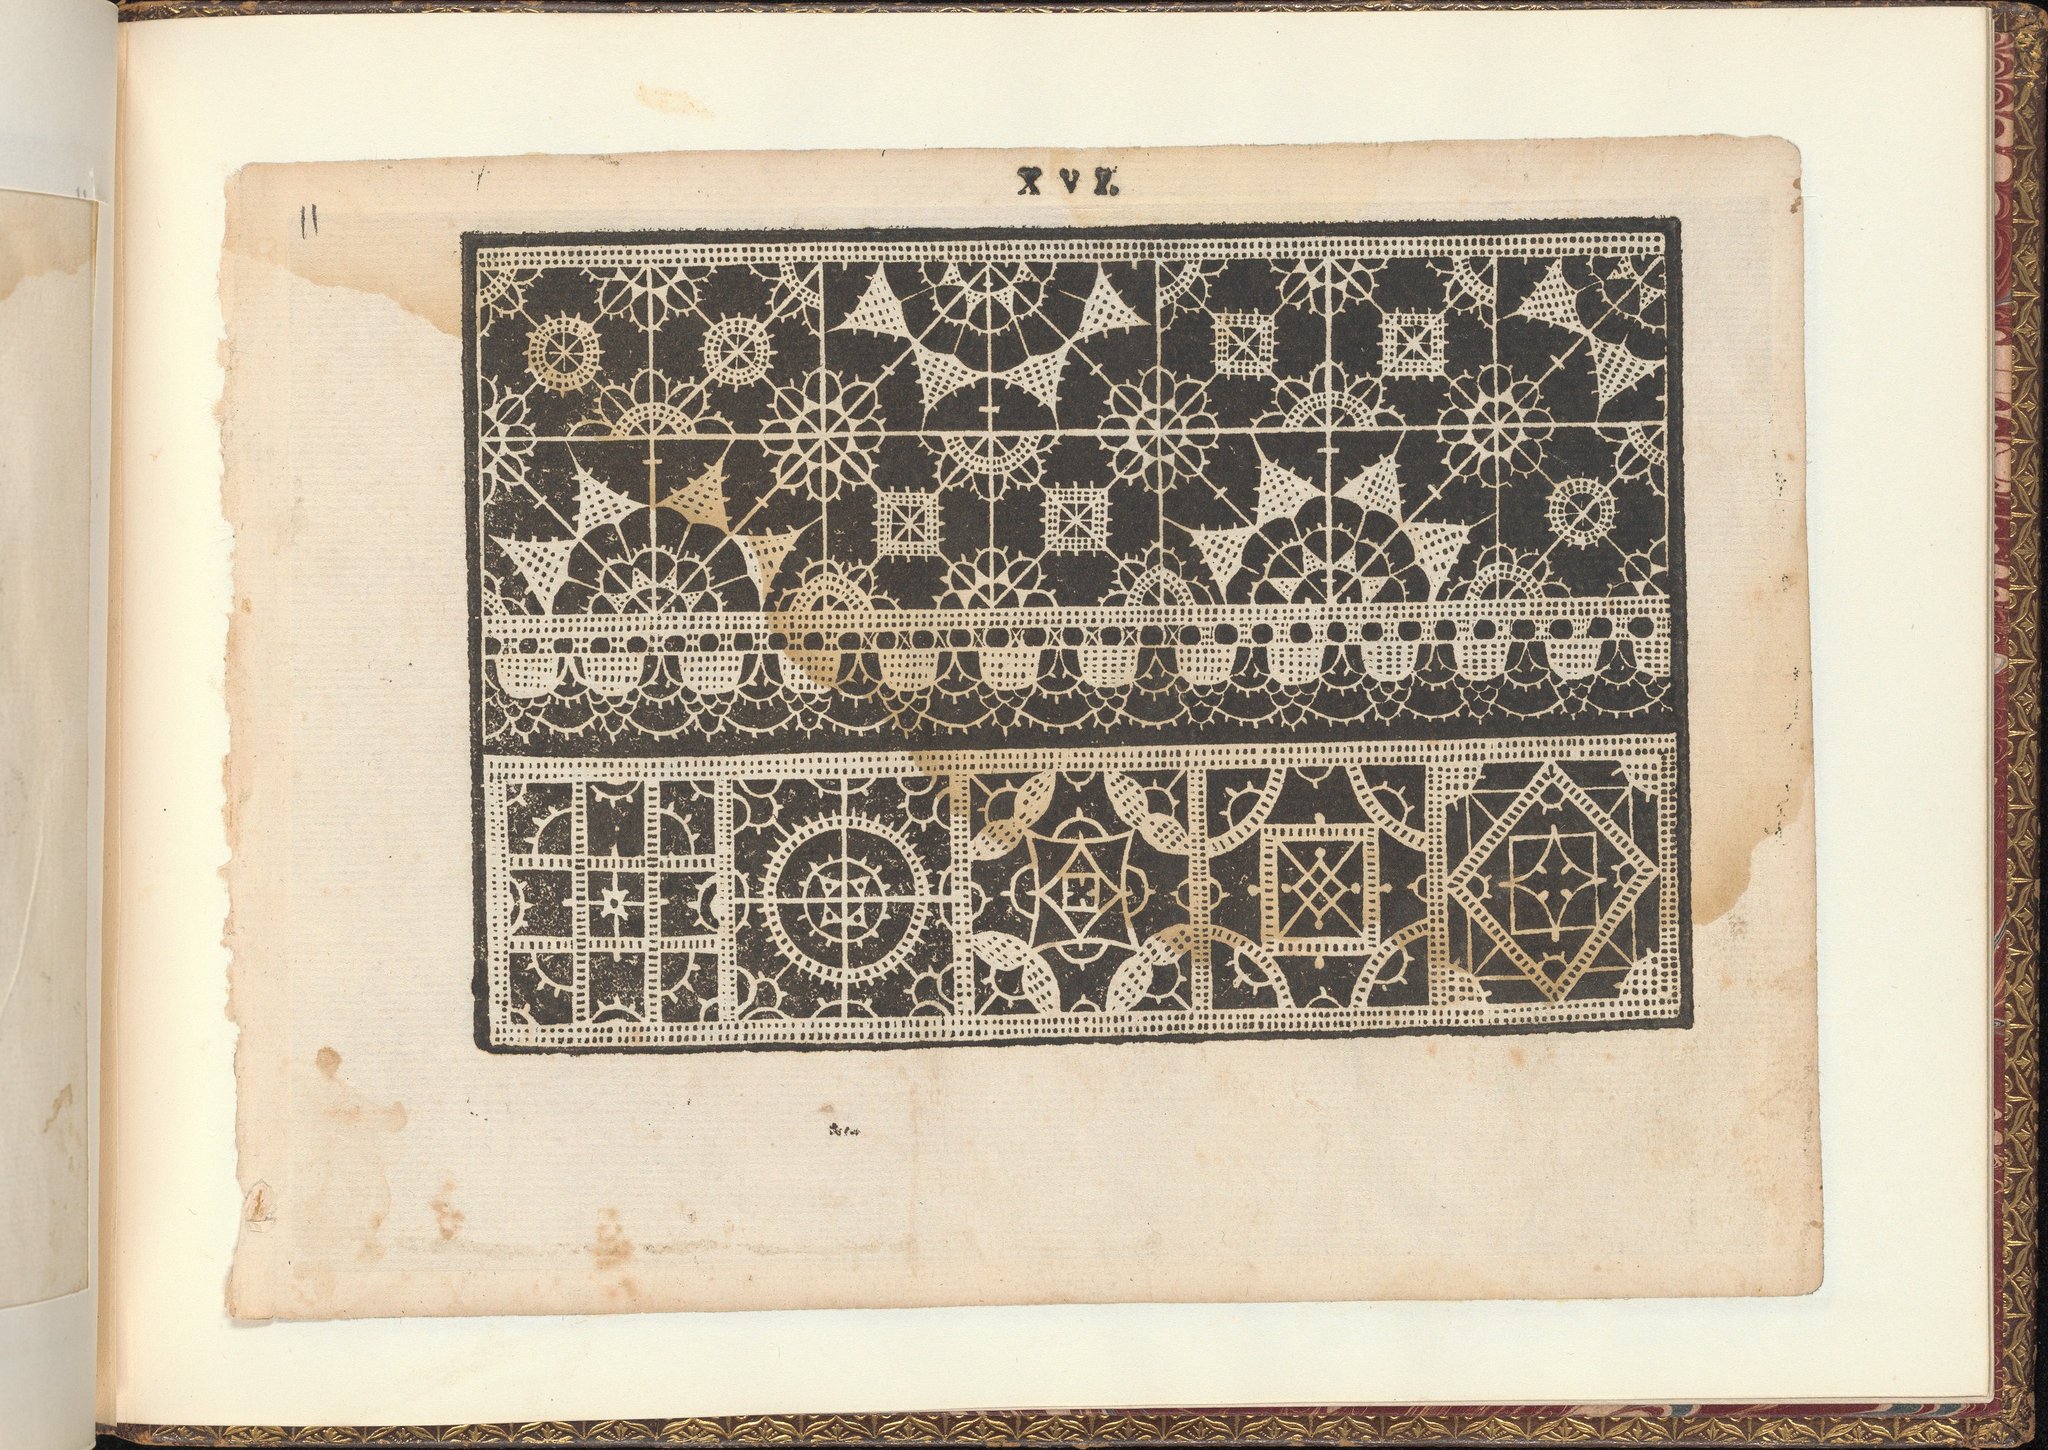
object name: book print ornament architecture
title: Prima parte de' fiori, page 12 (recto)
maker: giovanni battista ciotti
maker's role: author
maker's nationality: italian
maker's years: 1555-1659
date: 1591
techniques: woodcut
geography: italy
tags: ornament